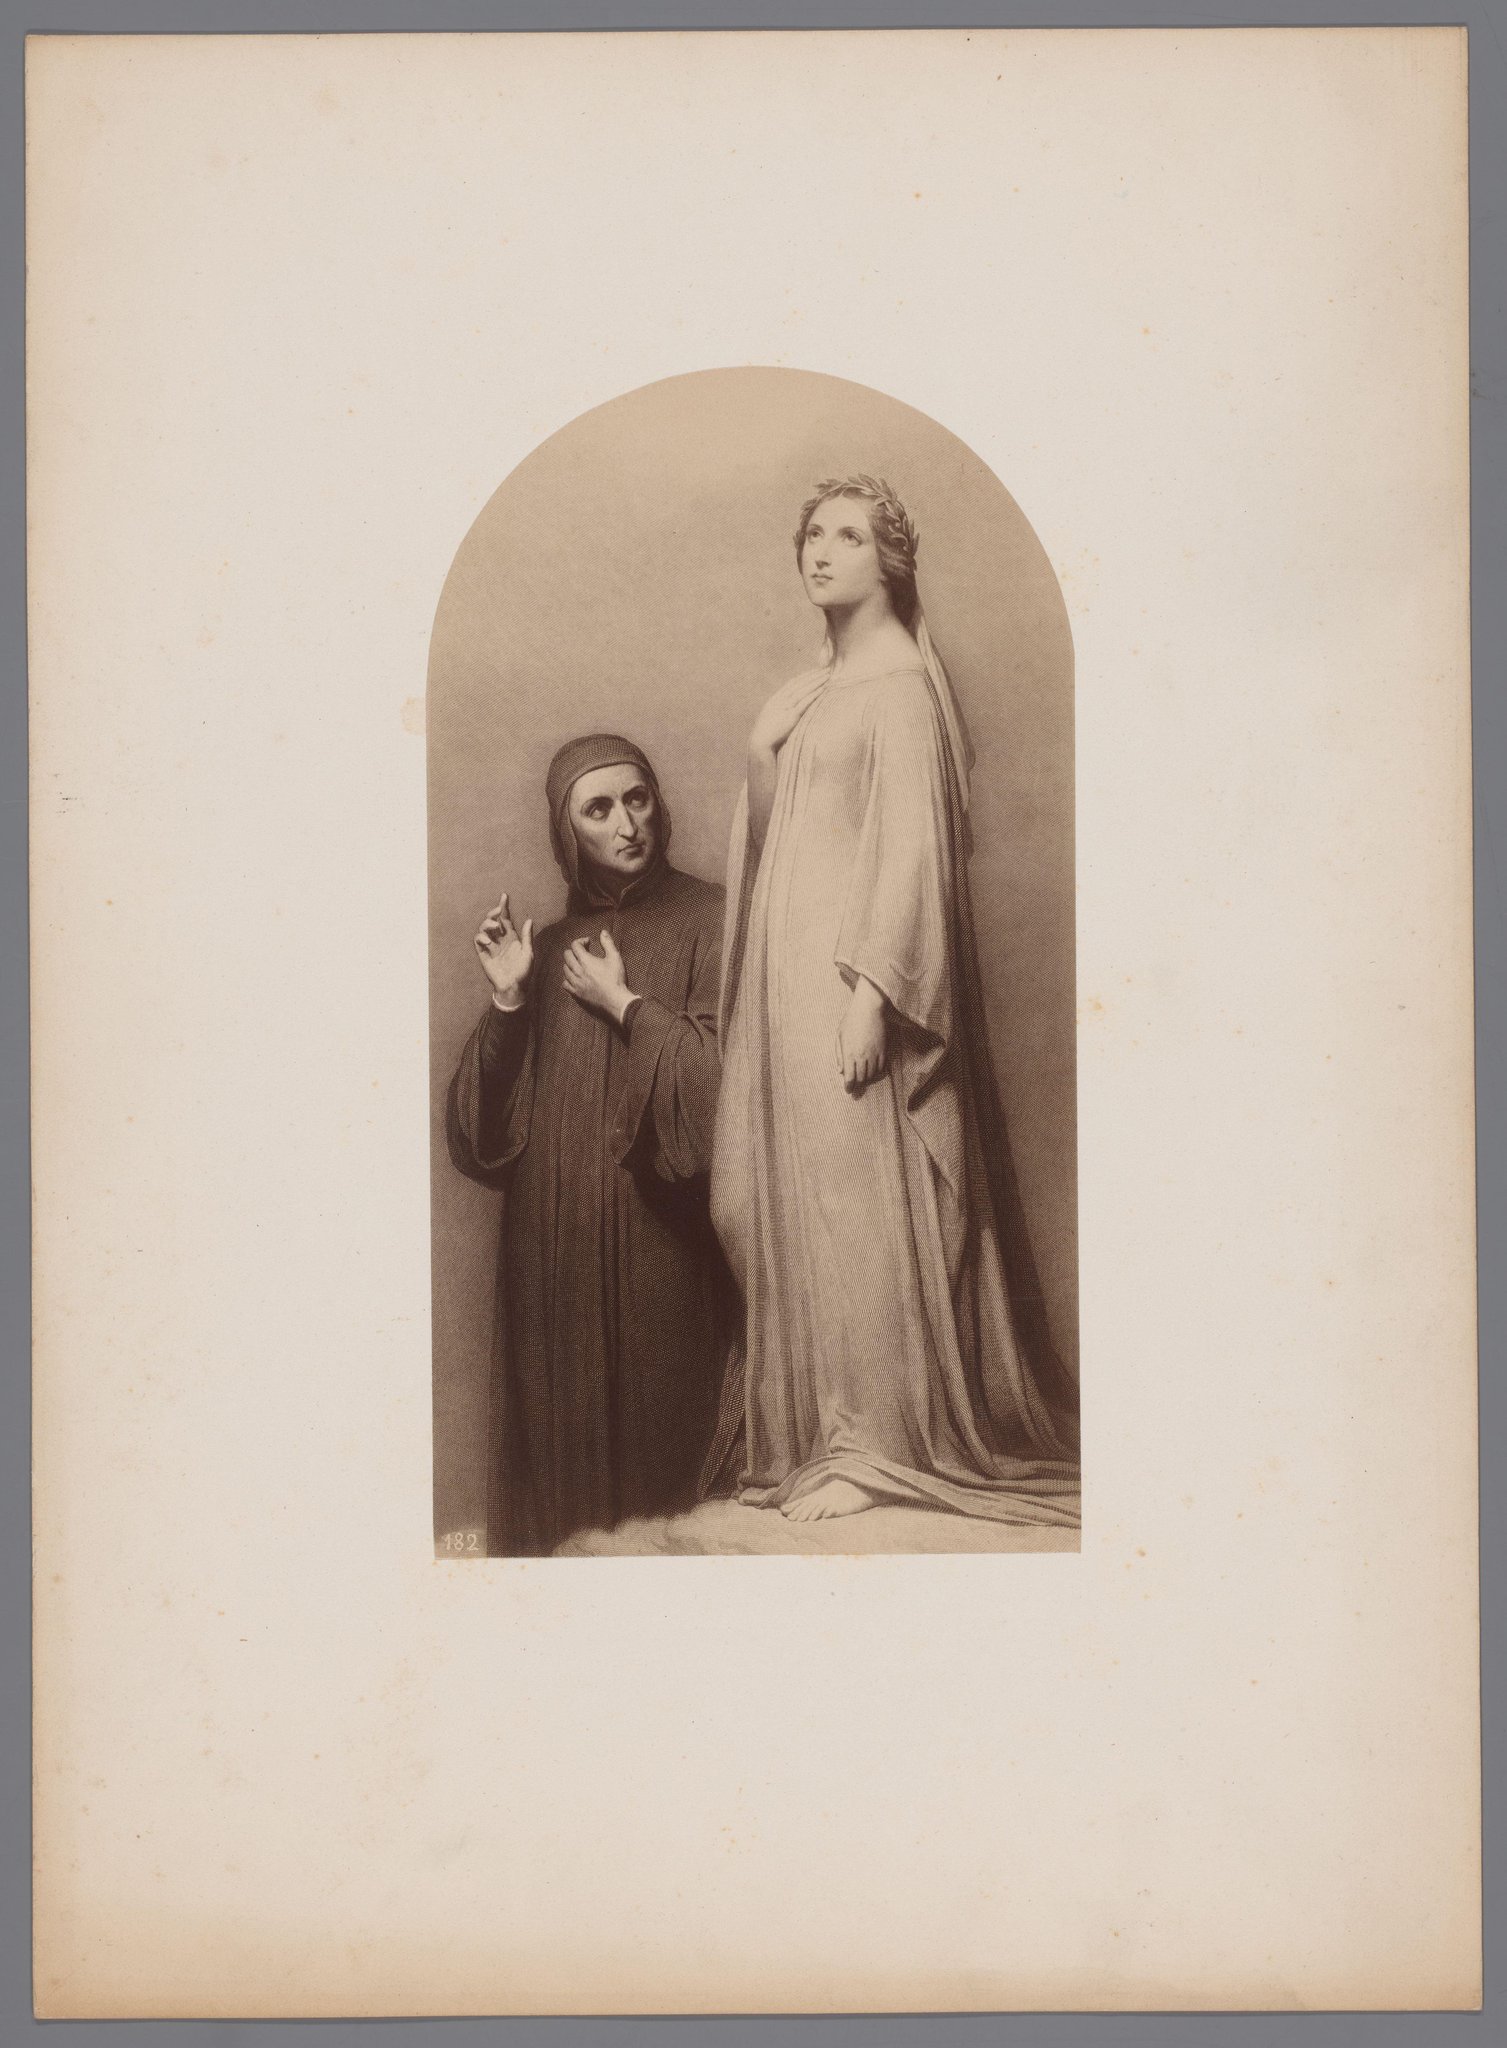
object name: photograph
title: Beatrice e Dante van Scheffer, foto naar gravure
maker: Anonymous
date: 1850-1900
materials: paper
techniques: albumen print